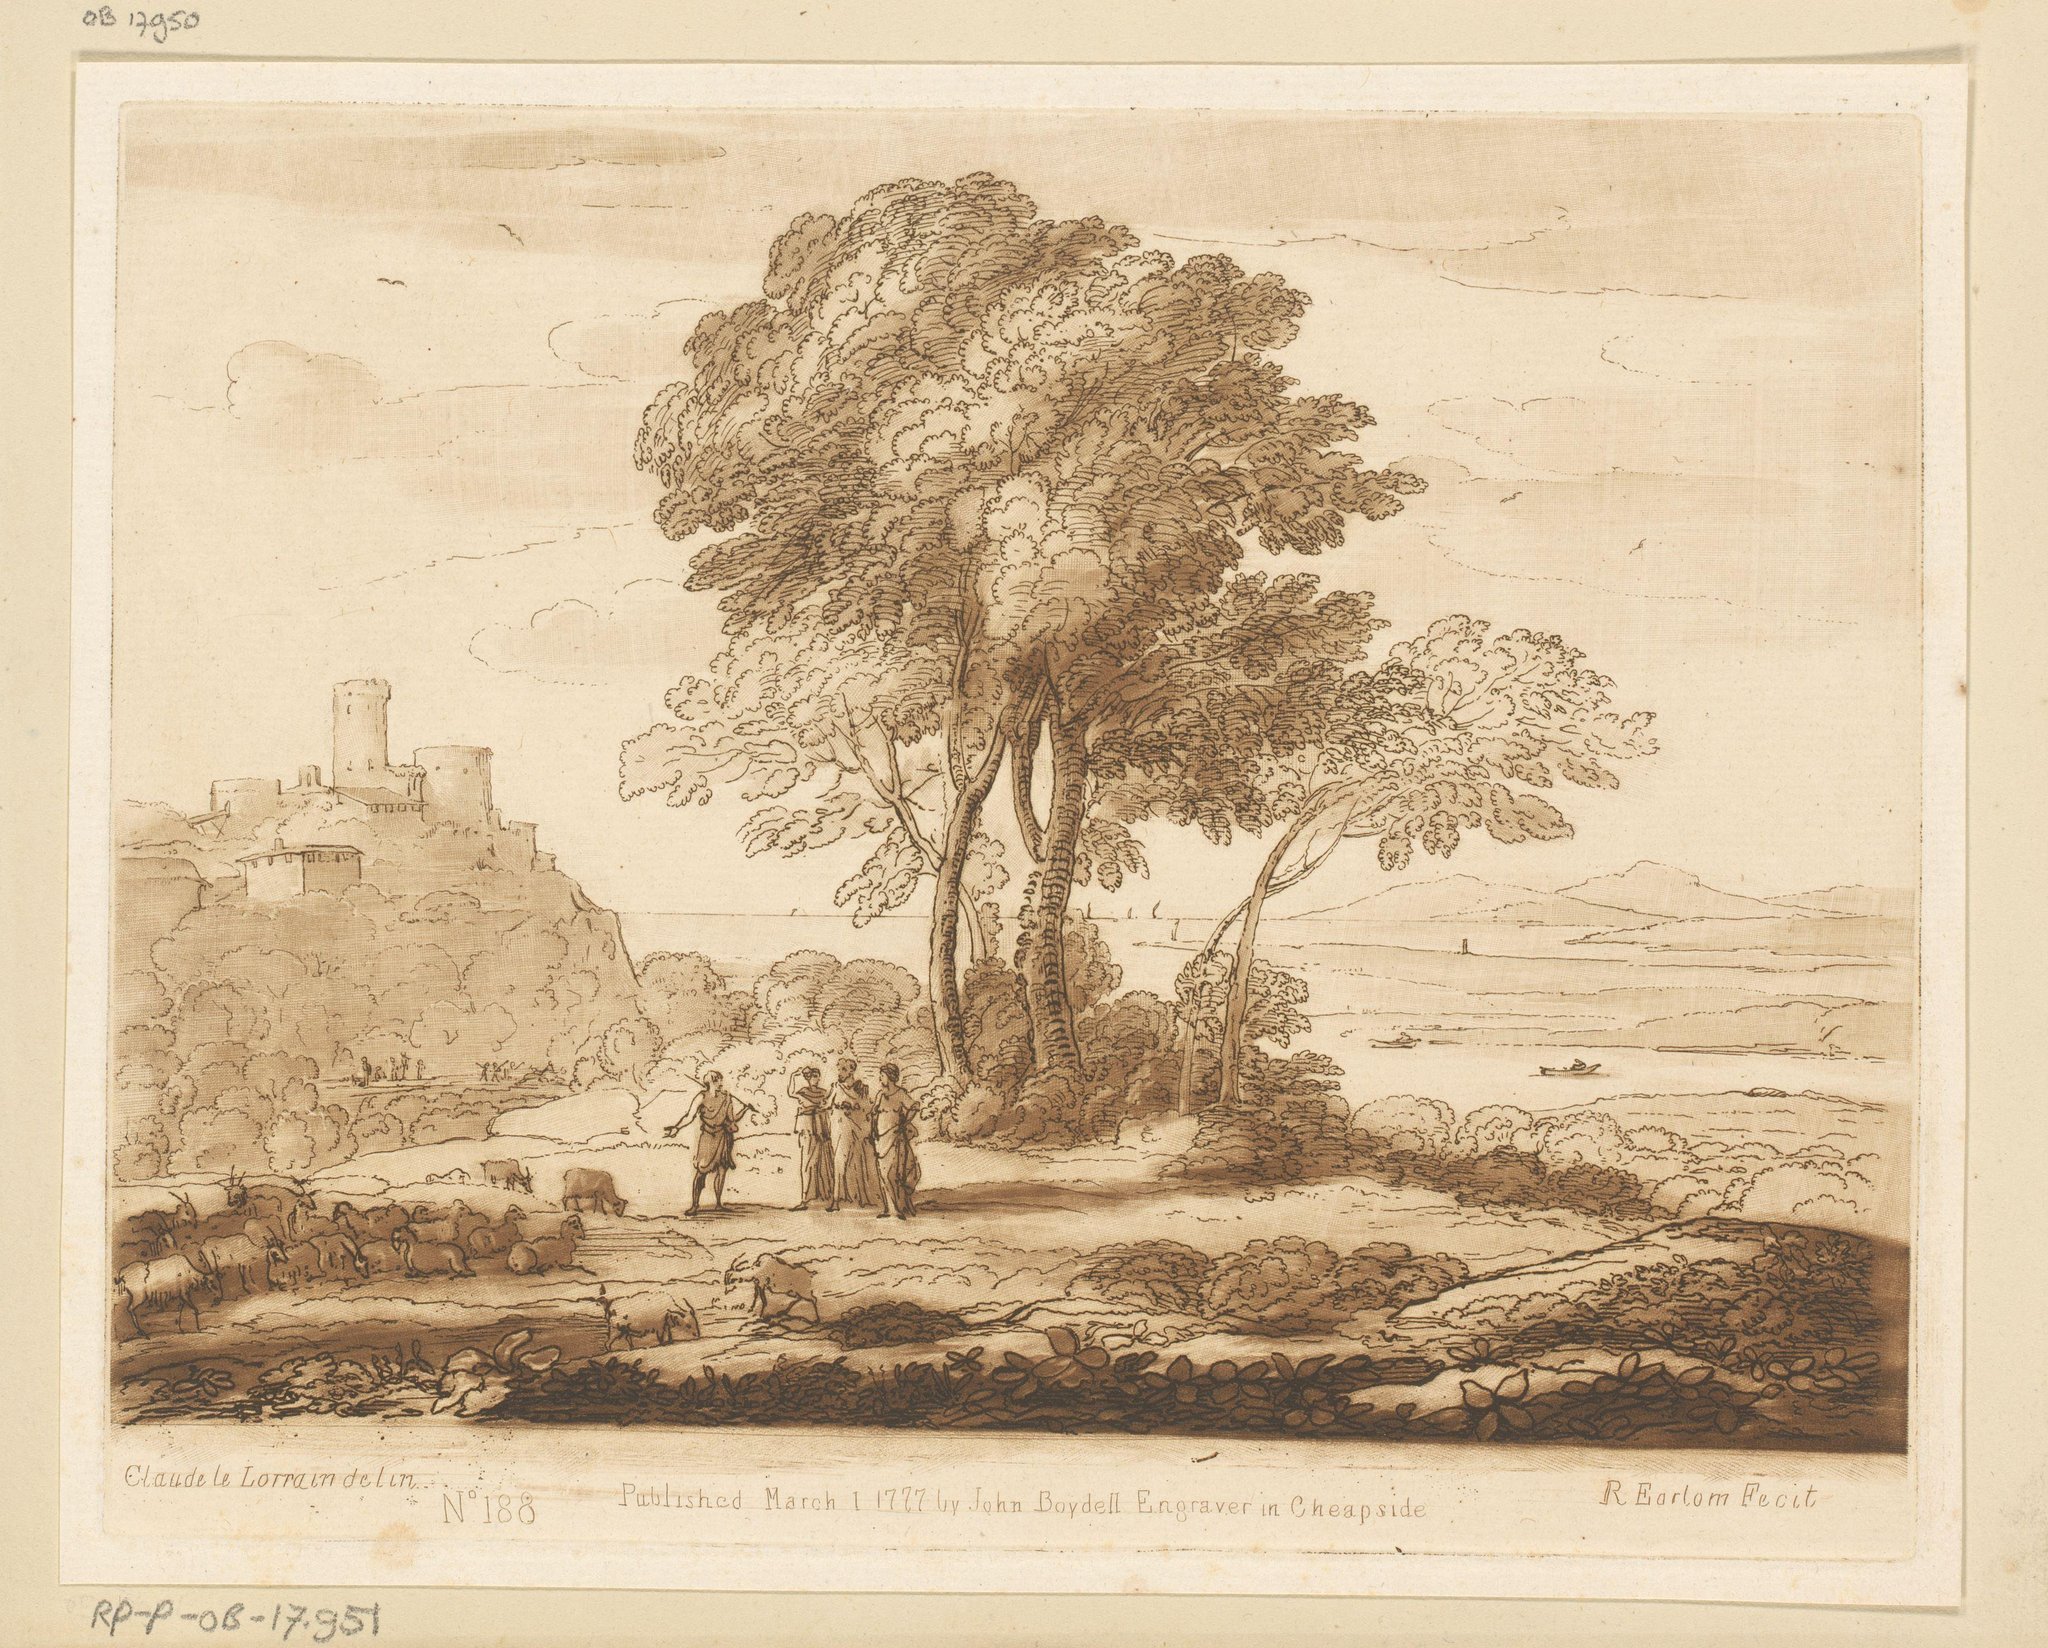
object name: print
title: Landschap met Jacob, Laban, Rachel en Lea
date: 1777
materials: paper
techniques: etching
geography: london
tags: coast - hh - ideal landscapes, cattle, village - ii - ideal landscapes, jacob serving laban for rachel and leah (genesis 29:14-30)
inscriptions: date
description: Vanaf 1774 publiceerde John Boydell tweehonderd prenten naar het tekeningenboek Liber Veritatis van Claude Lorrain, in het bezit van de hertogen van Cavendish. Deze prenten werden vanaf 1777 in twee volumes gebundeld uitgegeven.